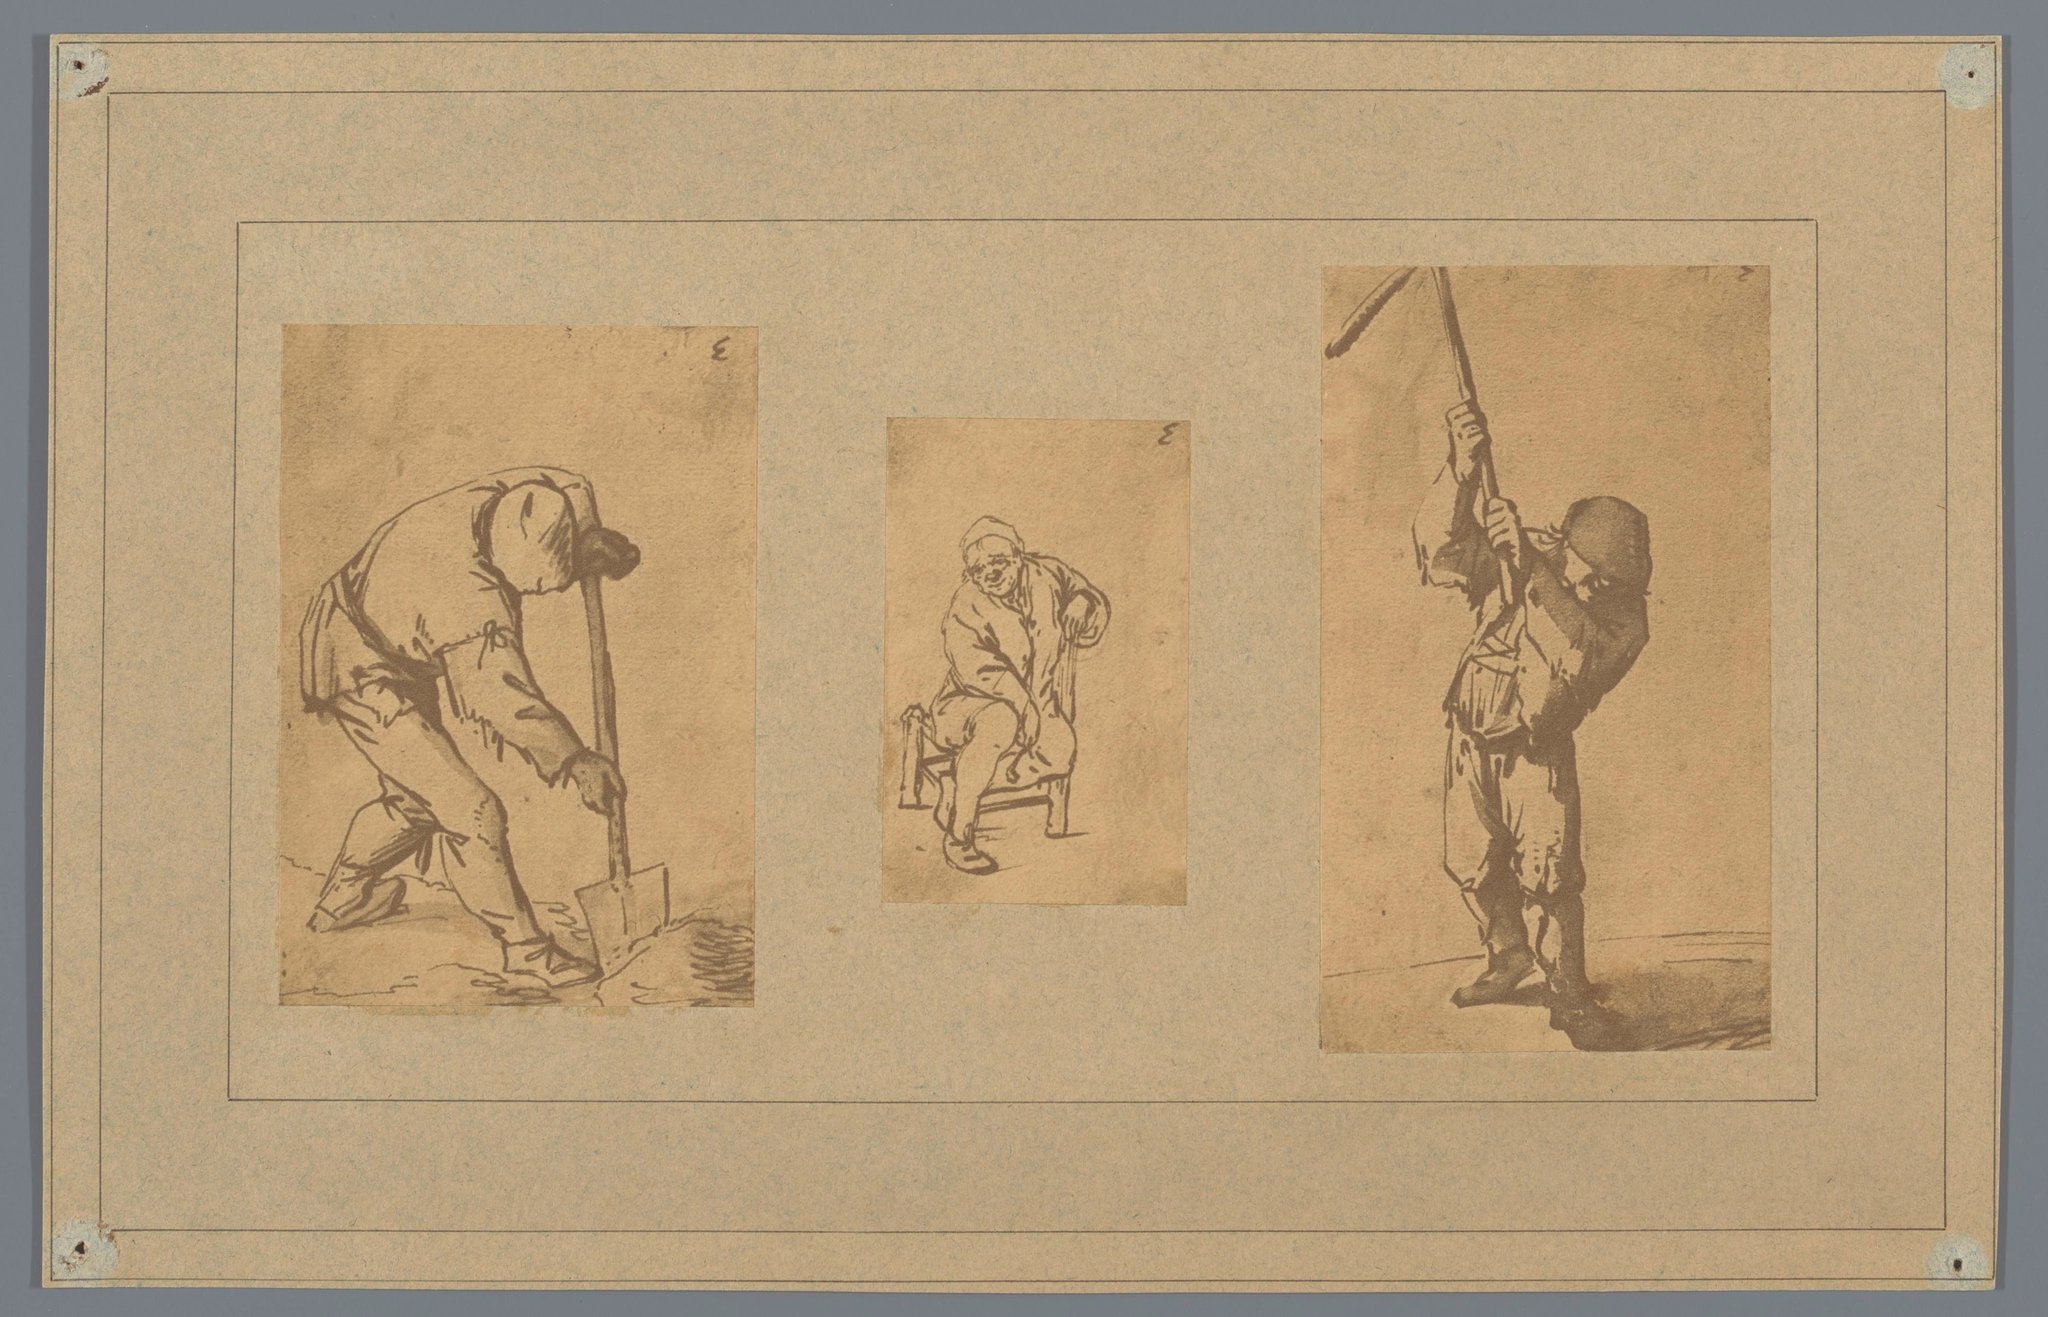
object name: photograph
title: Drie fotoreproducties van tekeningen van mannen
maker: Anonymous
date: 1875-1900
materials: cardboard, paper, pigment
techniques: carbon print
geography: europe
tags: sitting figure, working class, labourers, tools, aids, implements ~ crafts and industries: pickaxe, europe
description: Links een gravende man met een schop, midden een zittende man op een stoel, rechts een man met een pikhouweel.